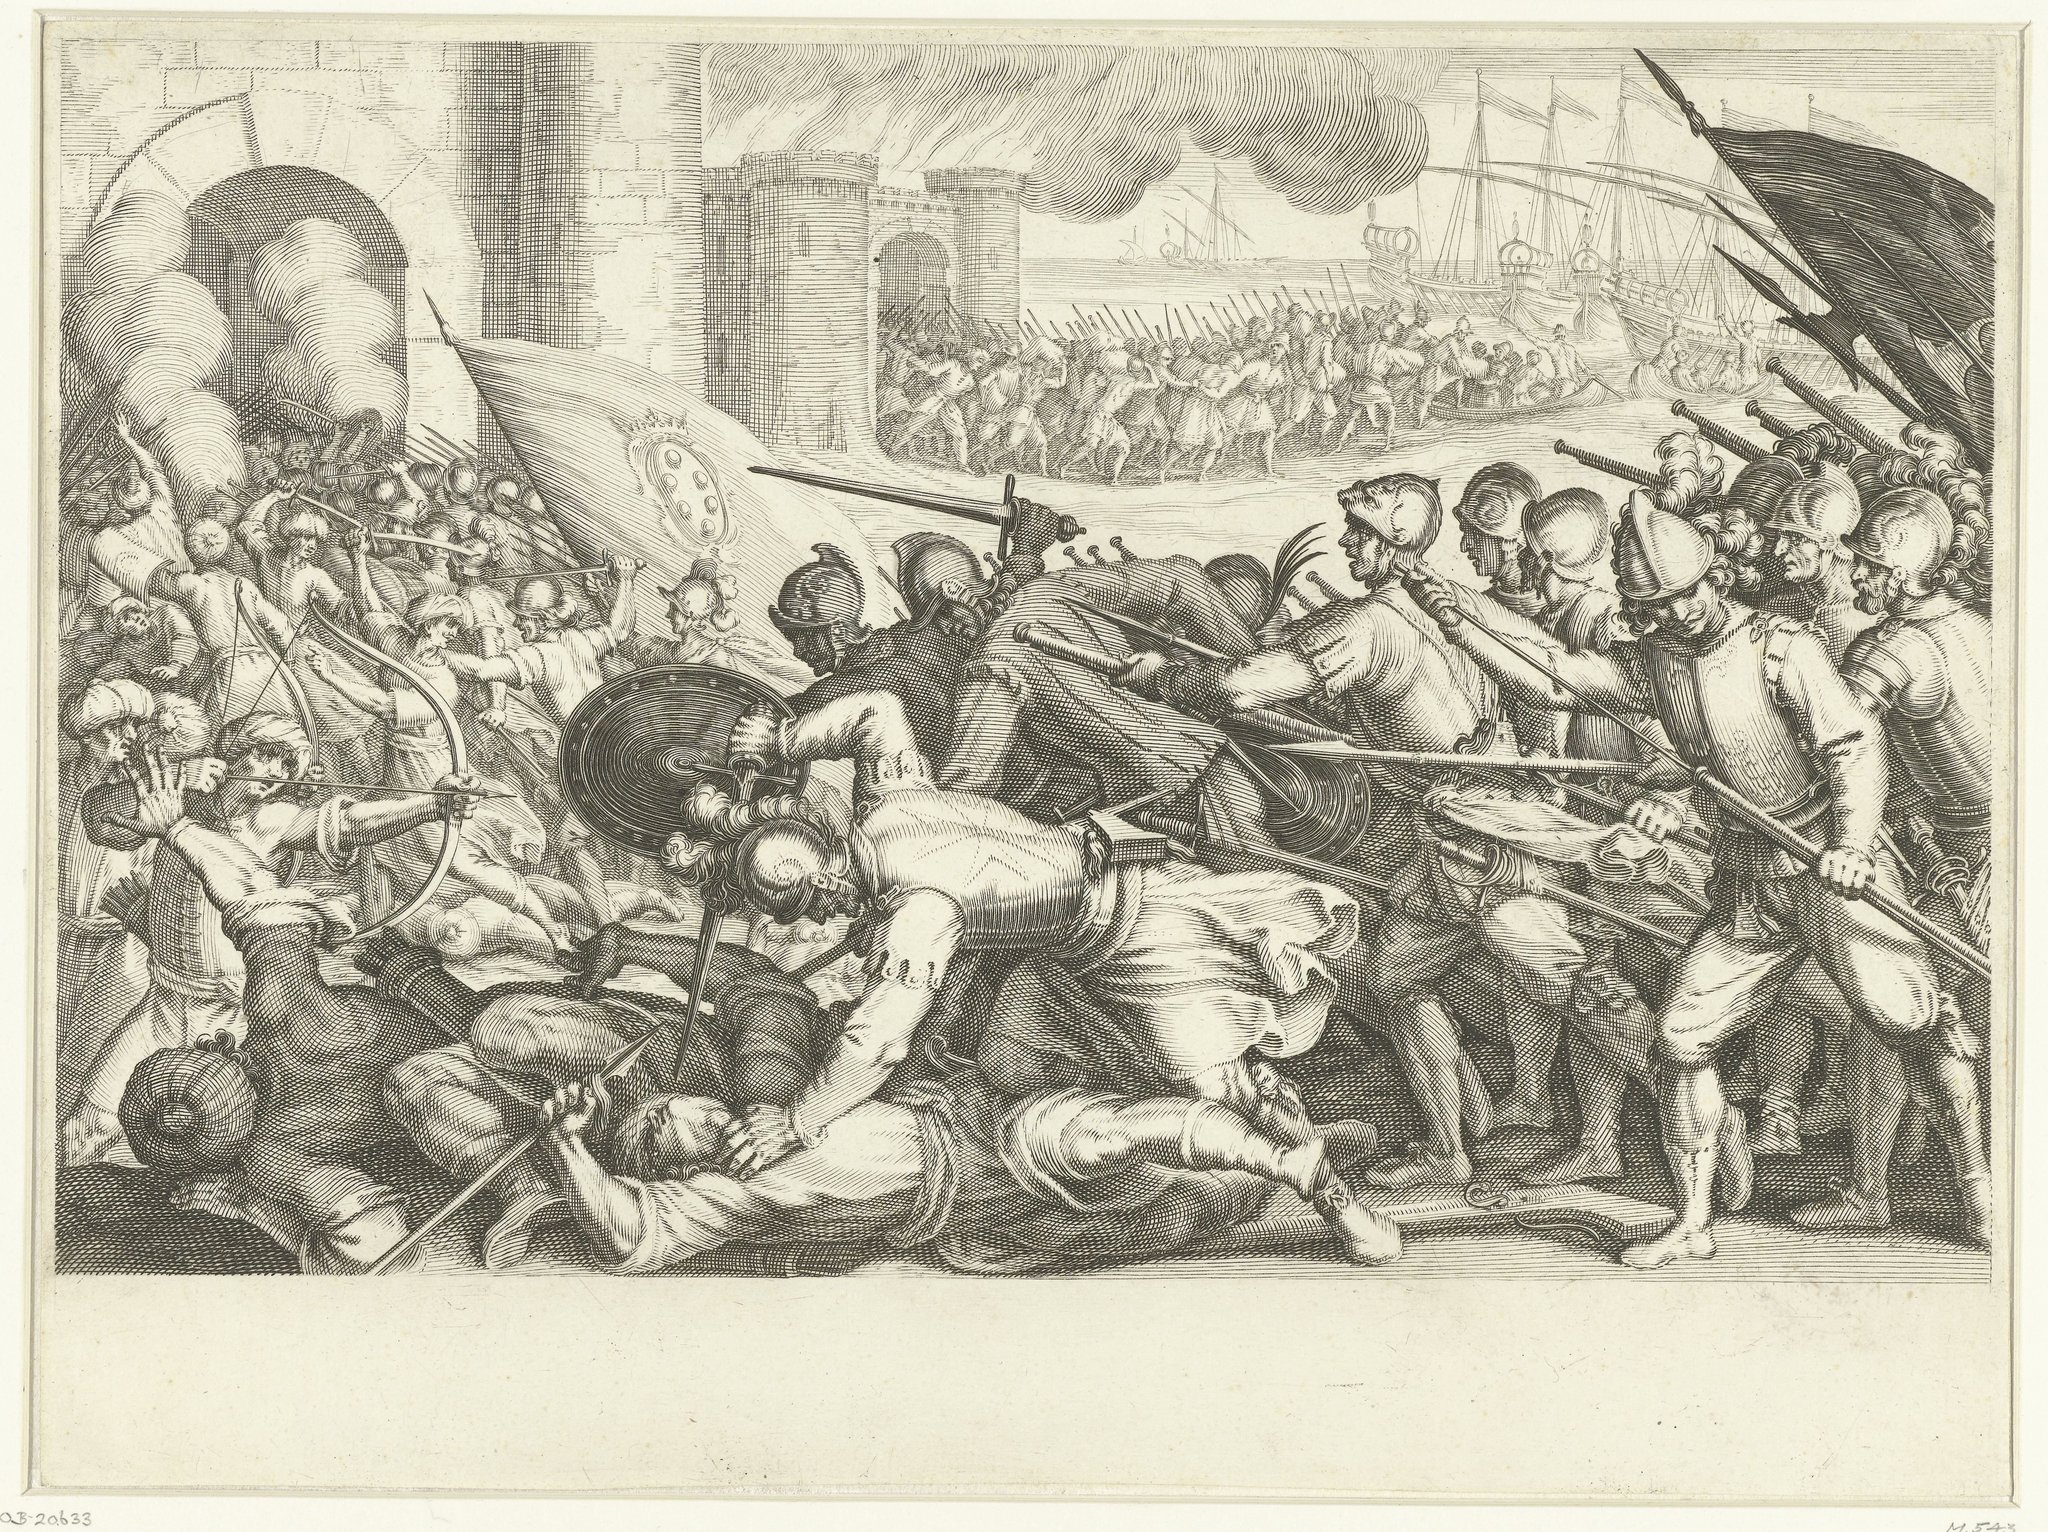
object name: print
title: De troepen van Ferdinando I de' Medici bestormen een stadspoort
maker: jacques callot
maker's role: draughtsman, print maker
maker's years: 1592-1635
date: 1614-1620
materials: paper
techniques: engraving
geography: florence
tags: ferdinando i de' medici, asiatic races and peoples: turks, battle, ships (in general), after the battle, city-gate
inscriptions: collector's mark: Lugt 240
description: Op de voorgrond strijden de soldaten van Ferdinando I de' Medici bij een stadspoort tegen Turkse soldaten. Op de achtergrond vertrekken zij door een andere stadspoort met hun oorlogsbuit. Onder de voorstelling een lege marge. Deze prent is onderdeel van een serie van 16 prenten (plus 2 onvoltooide prenten) van het leven van Ferdinando I de' Medici, bedoeld geweest als aanvulling op een reeds bestaande reeks illustraties van de geschiedenis van de Medicis.